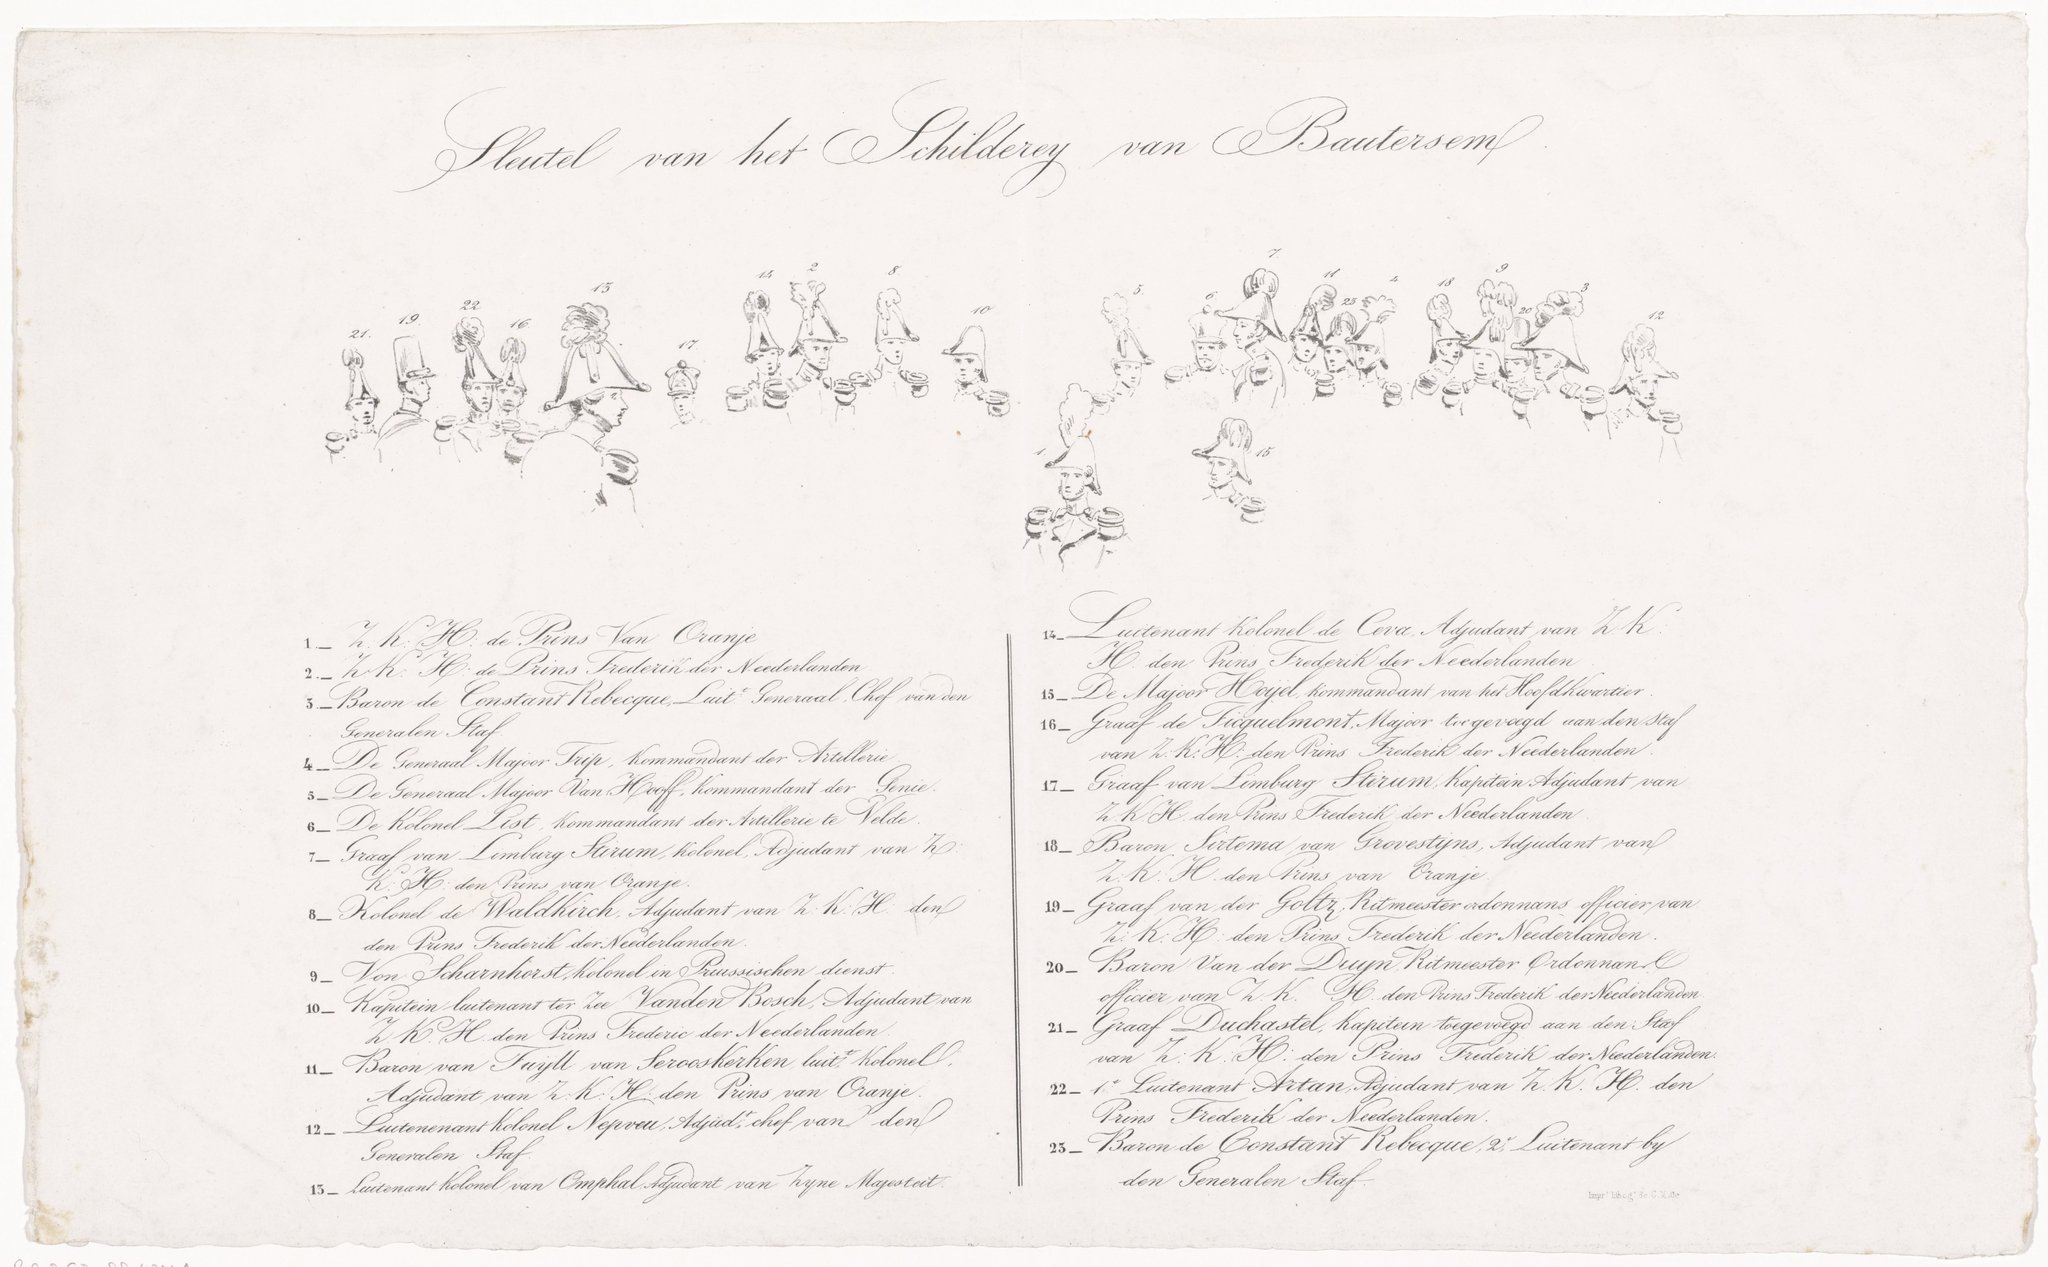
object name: print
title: Sleutel bij prent van de Slag bij Boutersem, 1831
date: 1831-1832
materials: paper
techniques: lithograph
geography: france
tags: the hague, william ii of the netherlands, fighting horses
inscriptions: collector's mark: Lugt 2228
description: Sleutel bij de prent van de Prins van Oranje bij de slag bij Boutersem, 12 augustus 1831. De namen van de voorgestelden in twee kolommen genummerd 1-23.